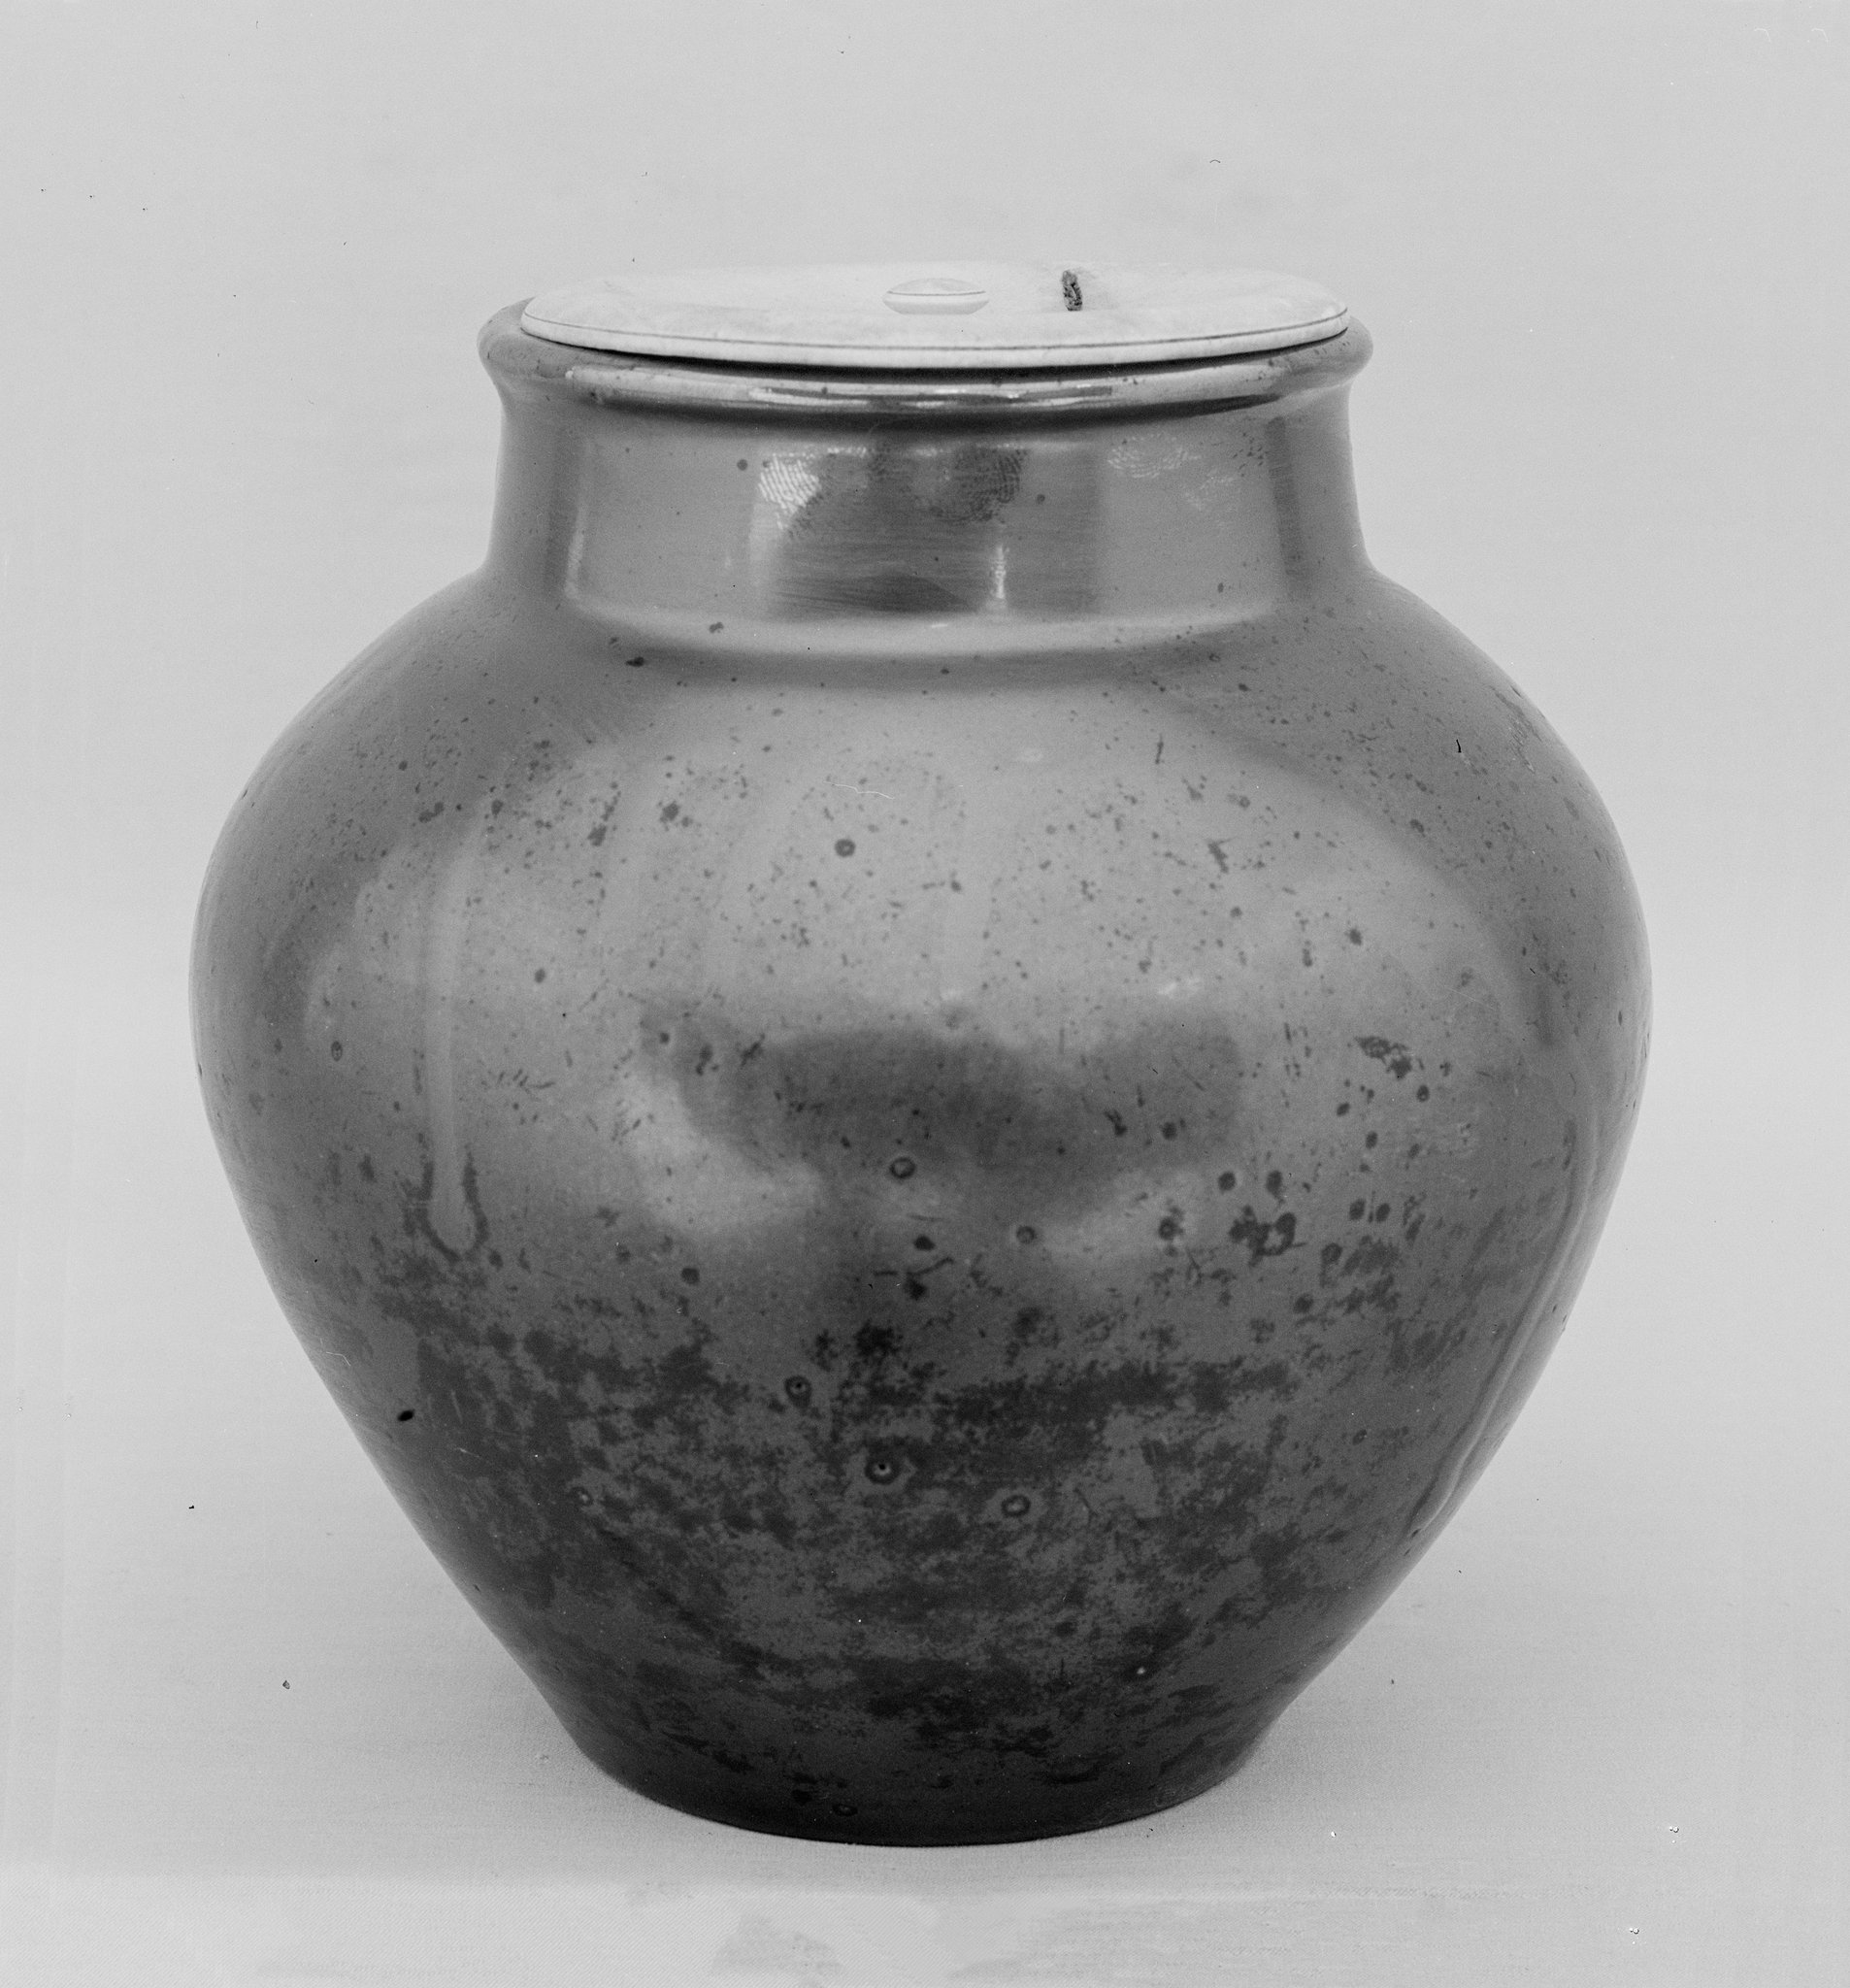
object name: jar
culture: japanese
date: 1801-1900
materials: clay, glaze